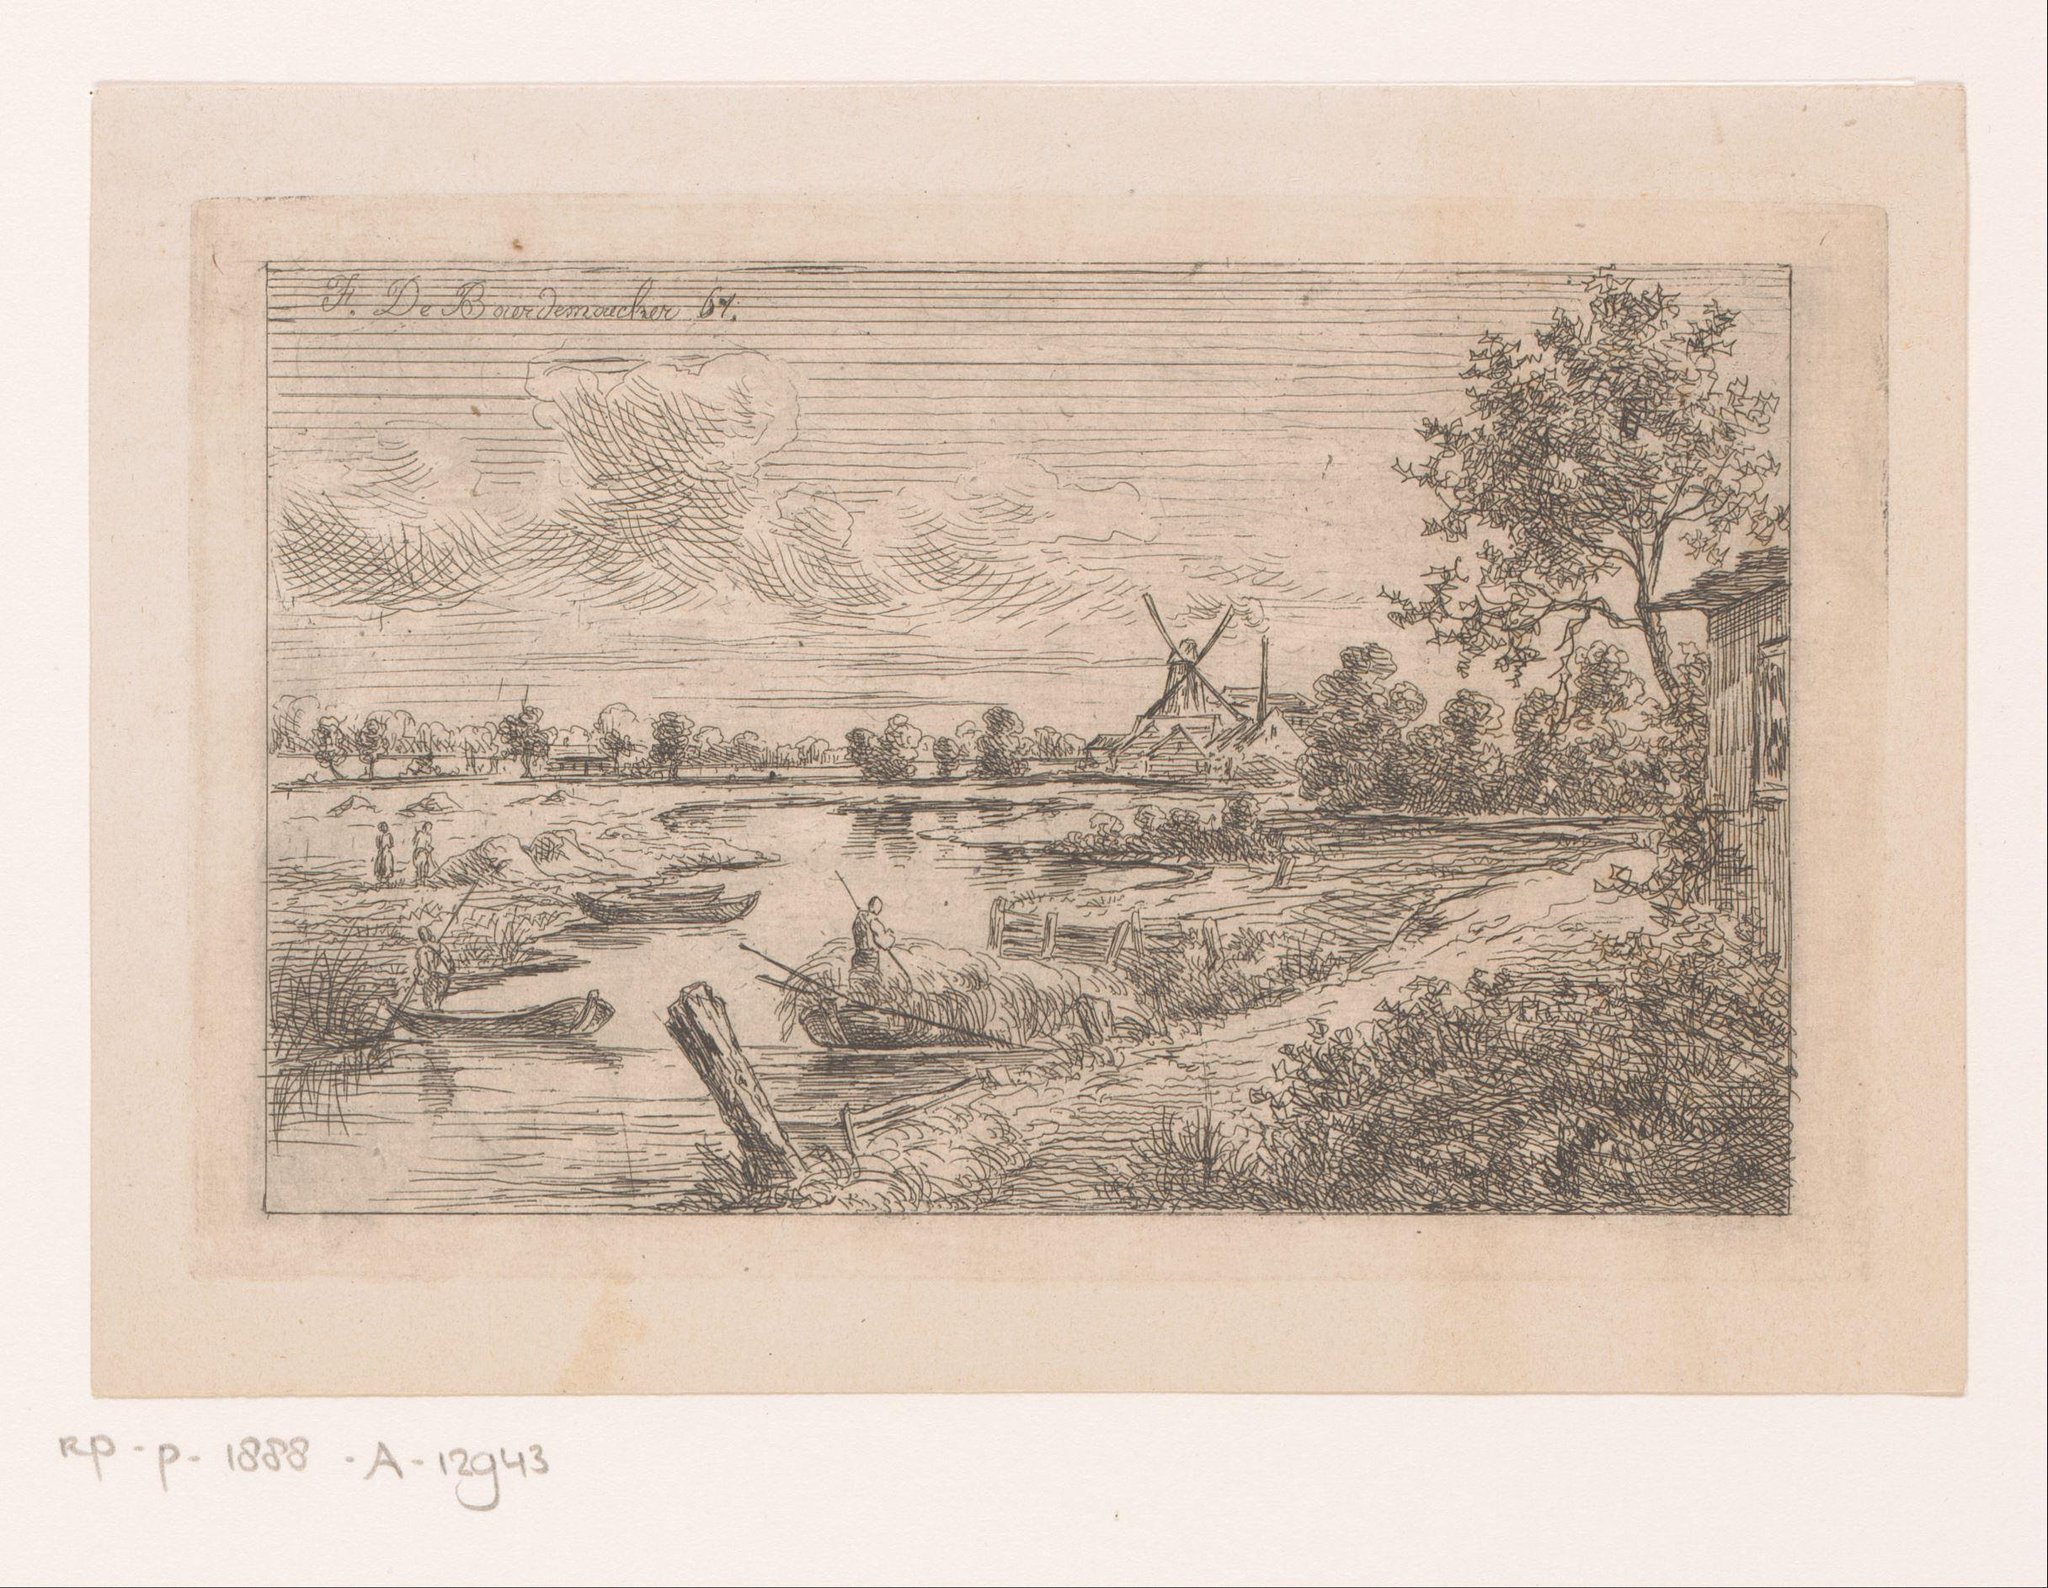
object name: print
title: Kanaal van Gent naar Brugge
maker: félix de baerdemaecker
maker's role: print maker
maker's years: 1836-1878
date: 1861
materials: paper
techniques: etching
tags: canal, rowing-boat, canoe, etc., windmill in landscape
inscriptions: collector's mark: Lugt 2228